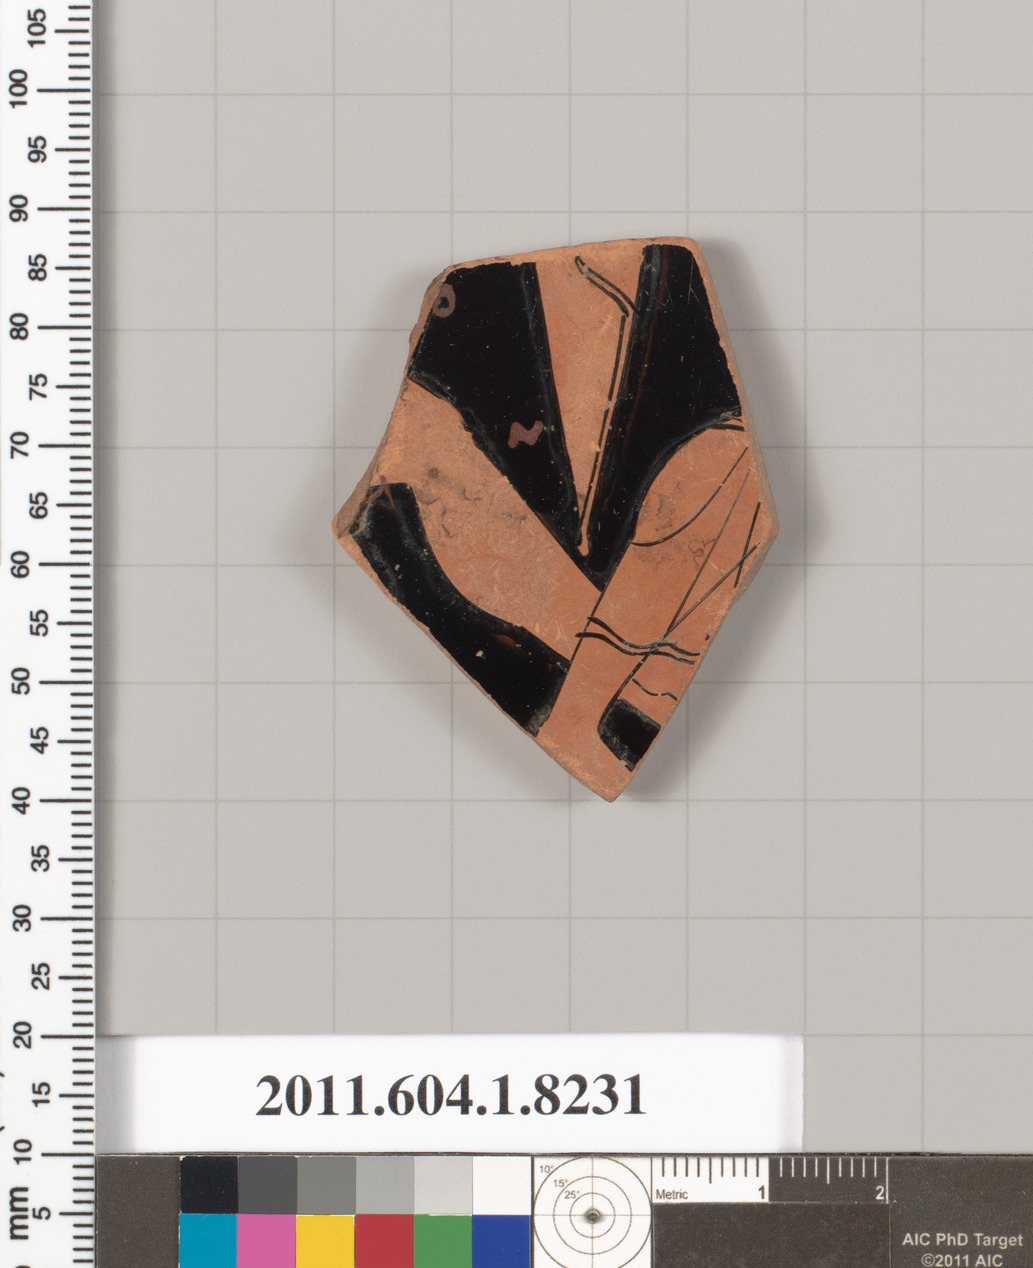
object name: kylix fragment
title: Terracotta fragment of a kylix (drinking cup)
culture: greek, attic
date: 520-510 BCE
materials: terracotta